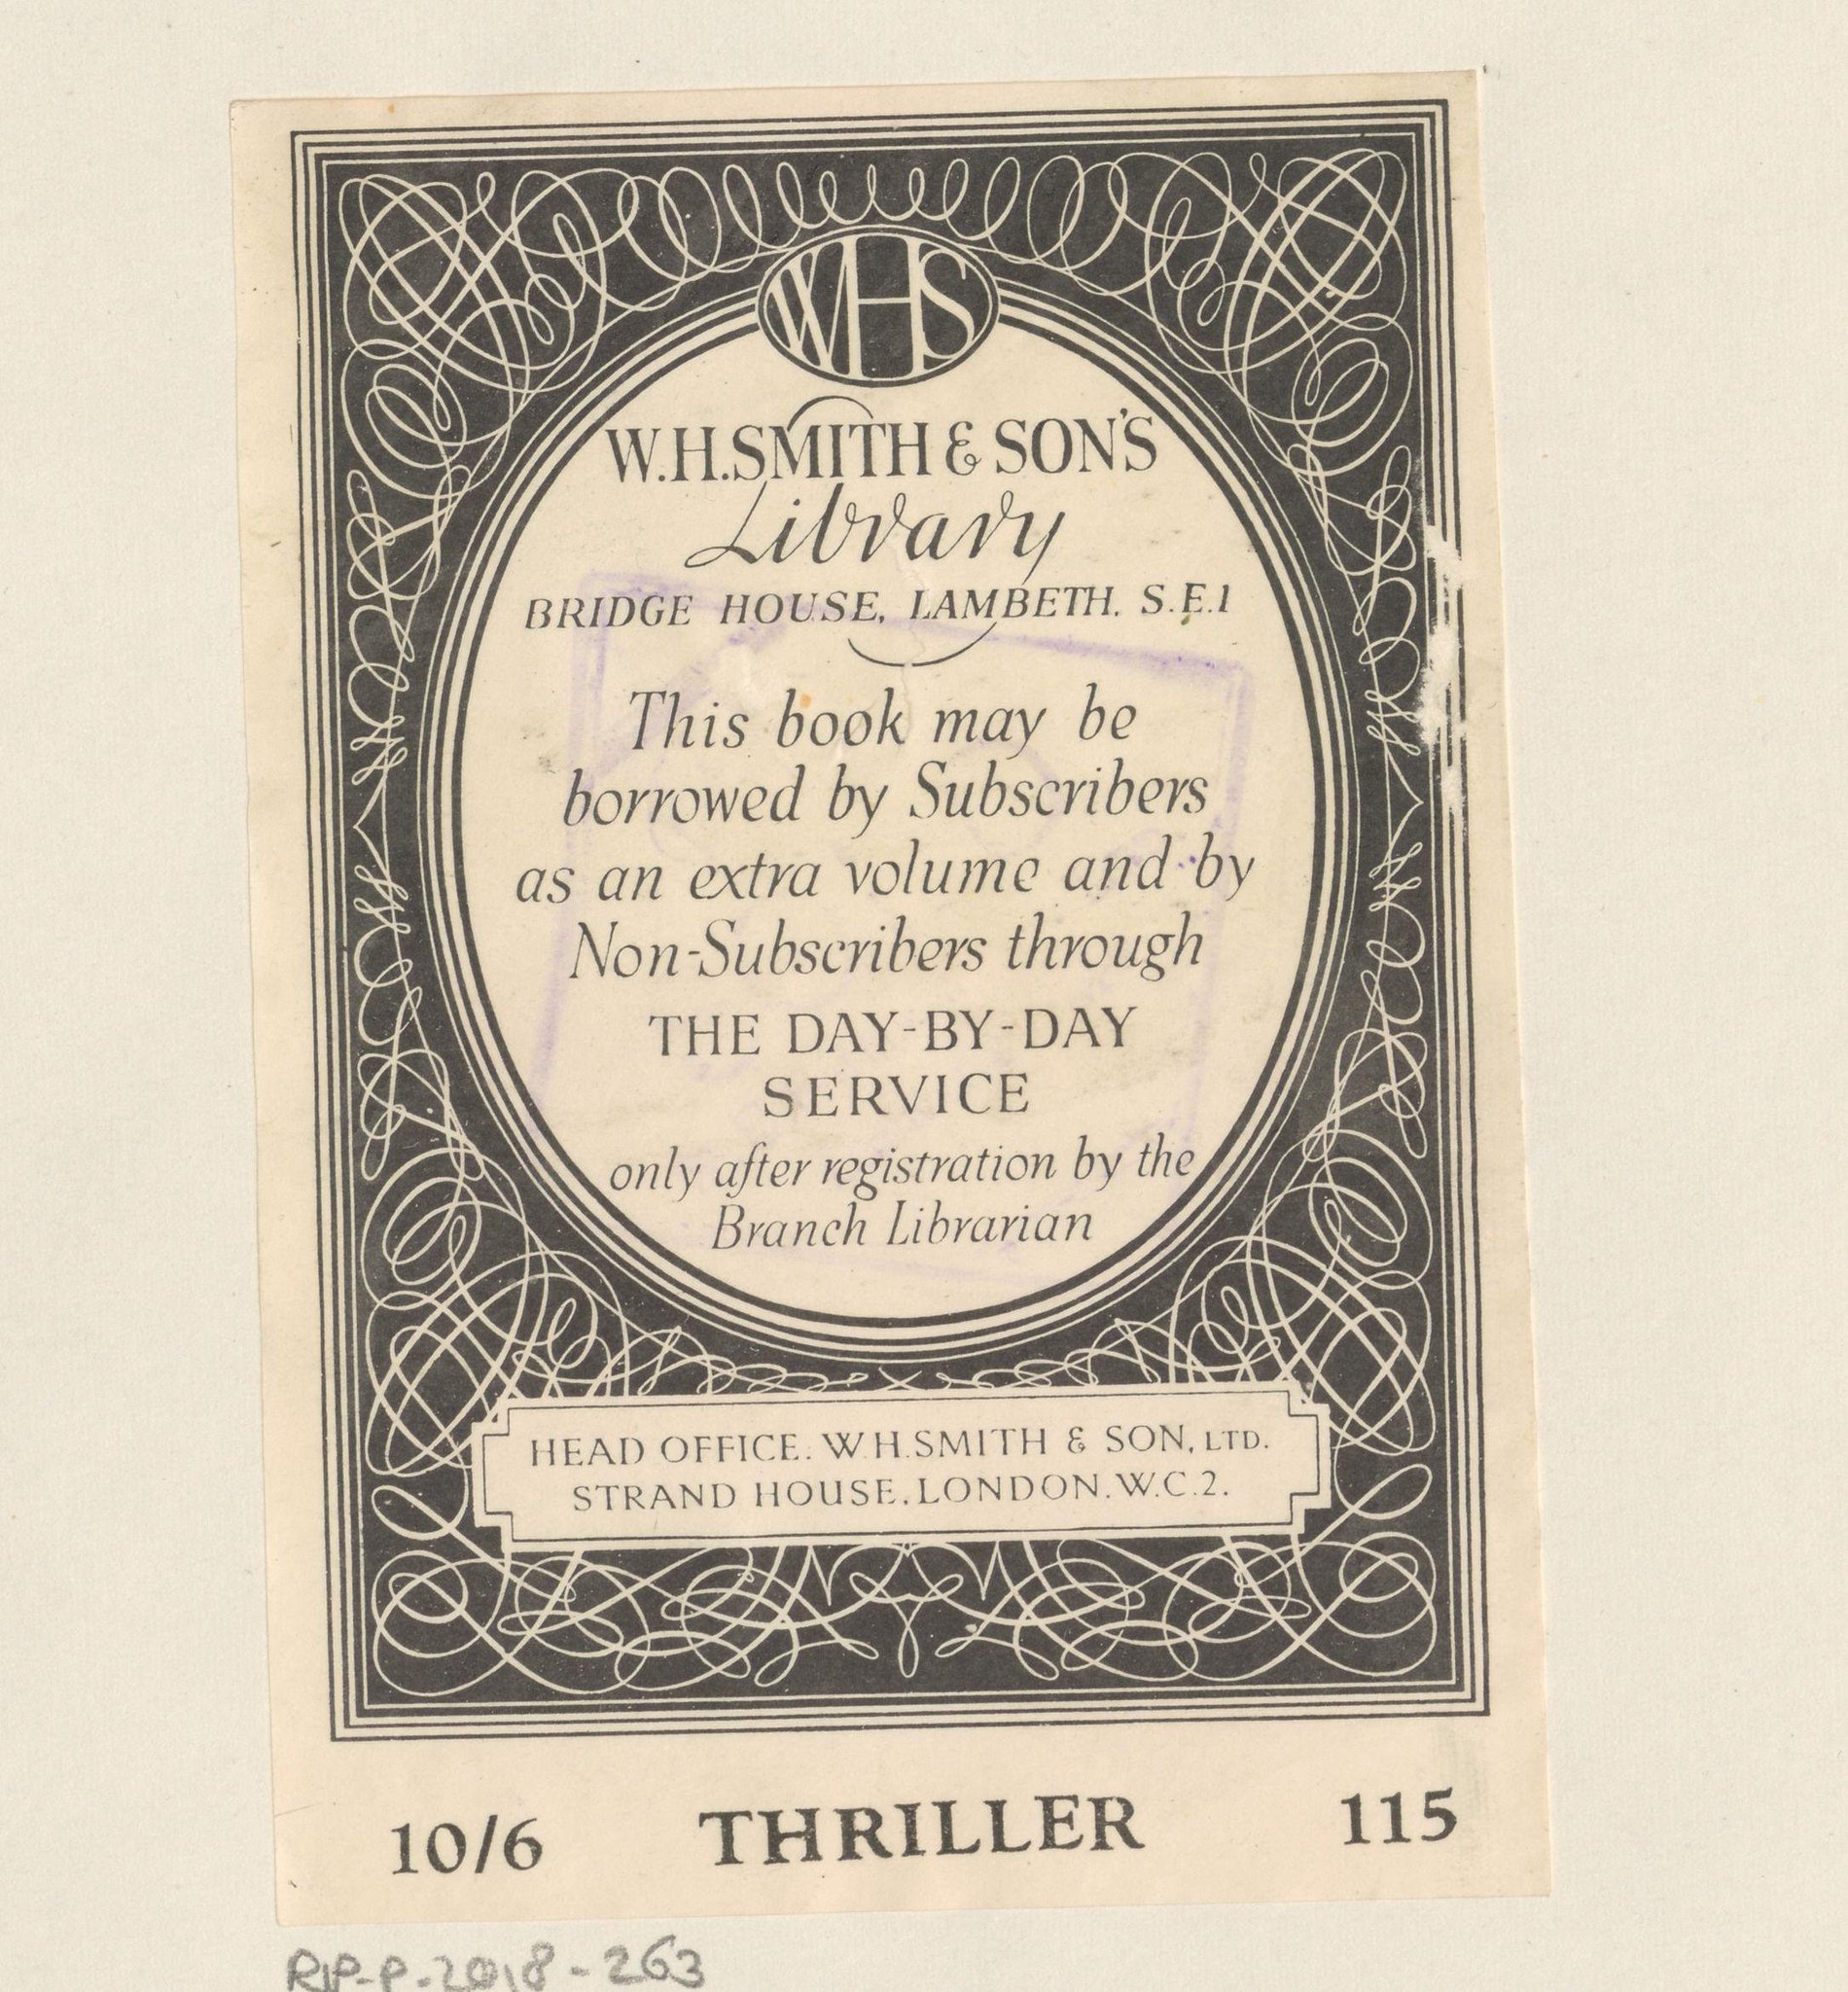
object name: bookplate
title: Ex libris van boekhandel W.H. Smith en zonen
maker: Anonymous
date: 1870-1949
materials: paper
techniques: printing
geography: england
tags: book-shop, bookseller